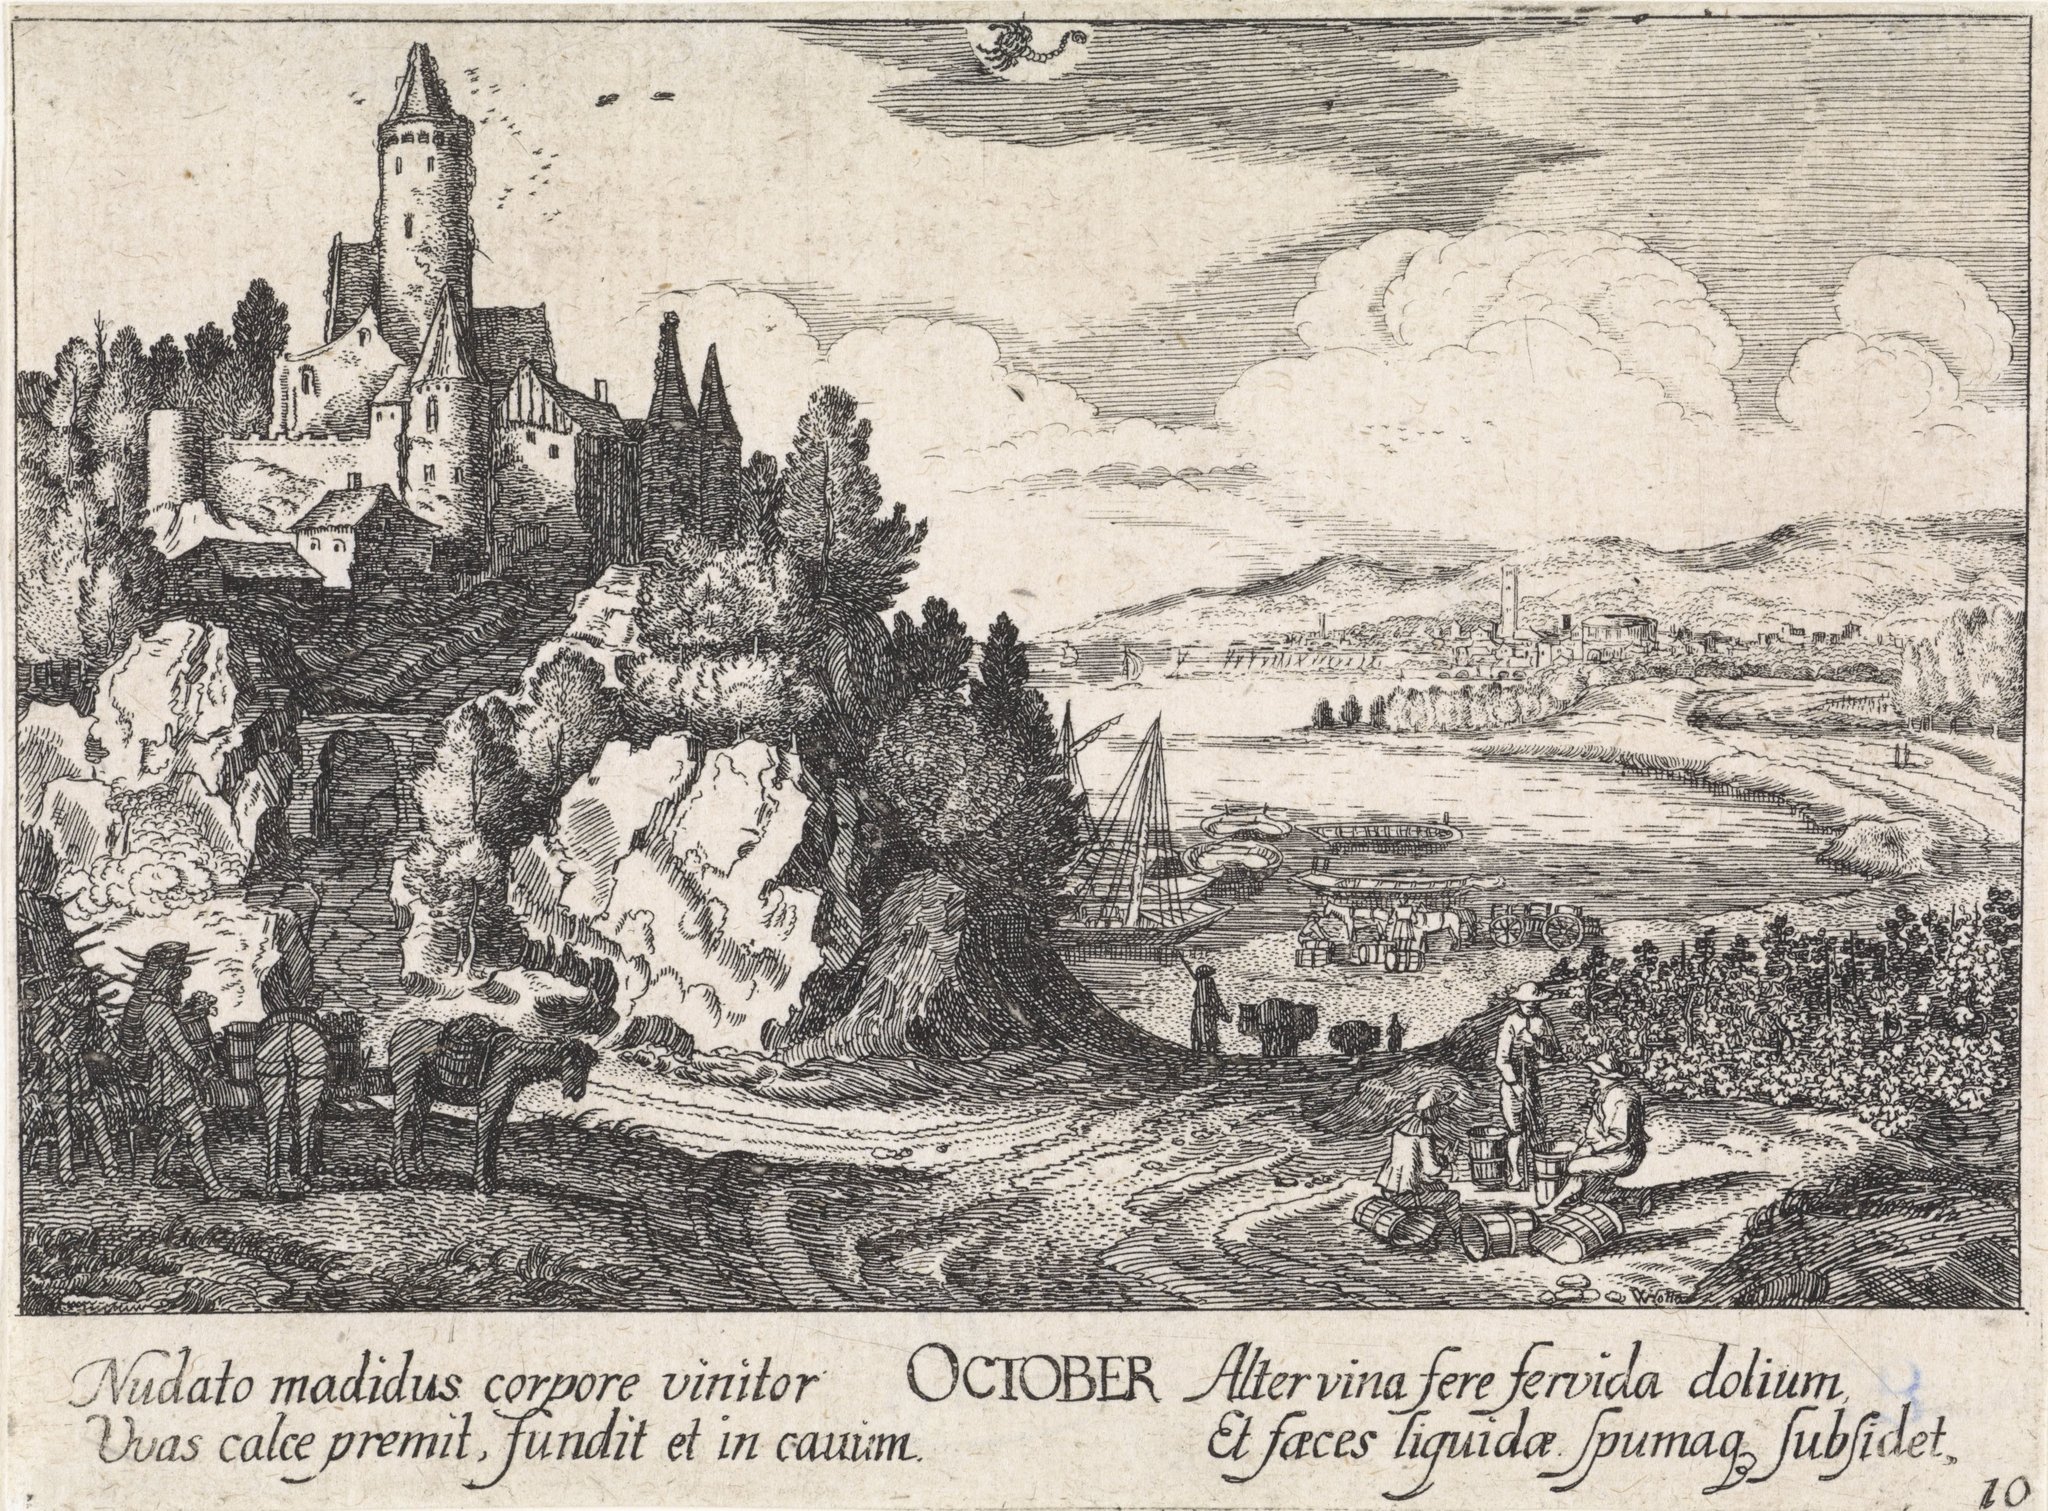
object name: print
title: October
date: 1684-1729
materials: paper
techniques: etching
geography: germany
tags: landscape symbolizing october, vineyard, castle, october and its 'labours', scorpio (zodiacal sign of october), vintage, grape harvest, viticulture, wine-growing; vintage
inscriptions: collector's mark: Lugt 2228, collector's mark: Lugt 384, collector's mark: Lugt 2760, collector's mark: Lugt 3790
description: Landschap met een kasteel op een berg aan een meer met rechts boeren met vaten bij wijnranken; een gezicht op Palermo op Sicilië, voorstellende de maand oktober. Bovenaan het bij deze maand behorende sterrenbeeld: schorpioen. Tiende prent uit een serie van twaalf.